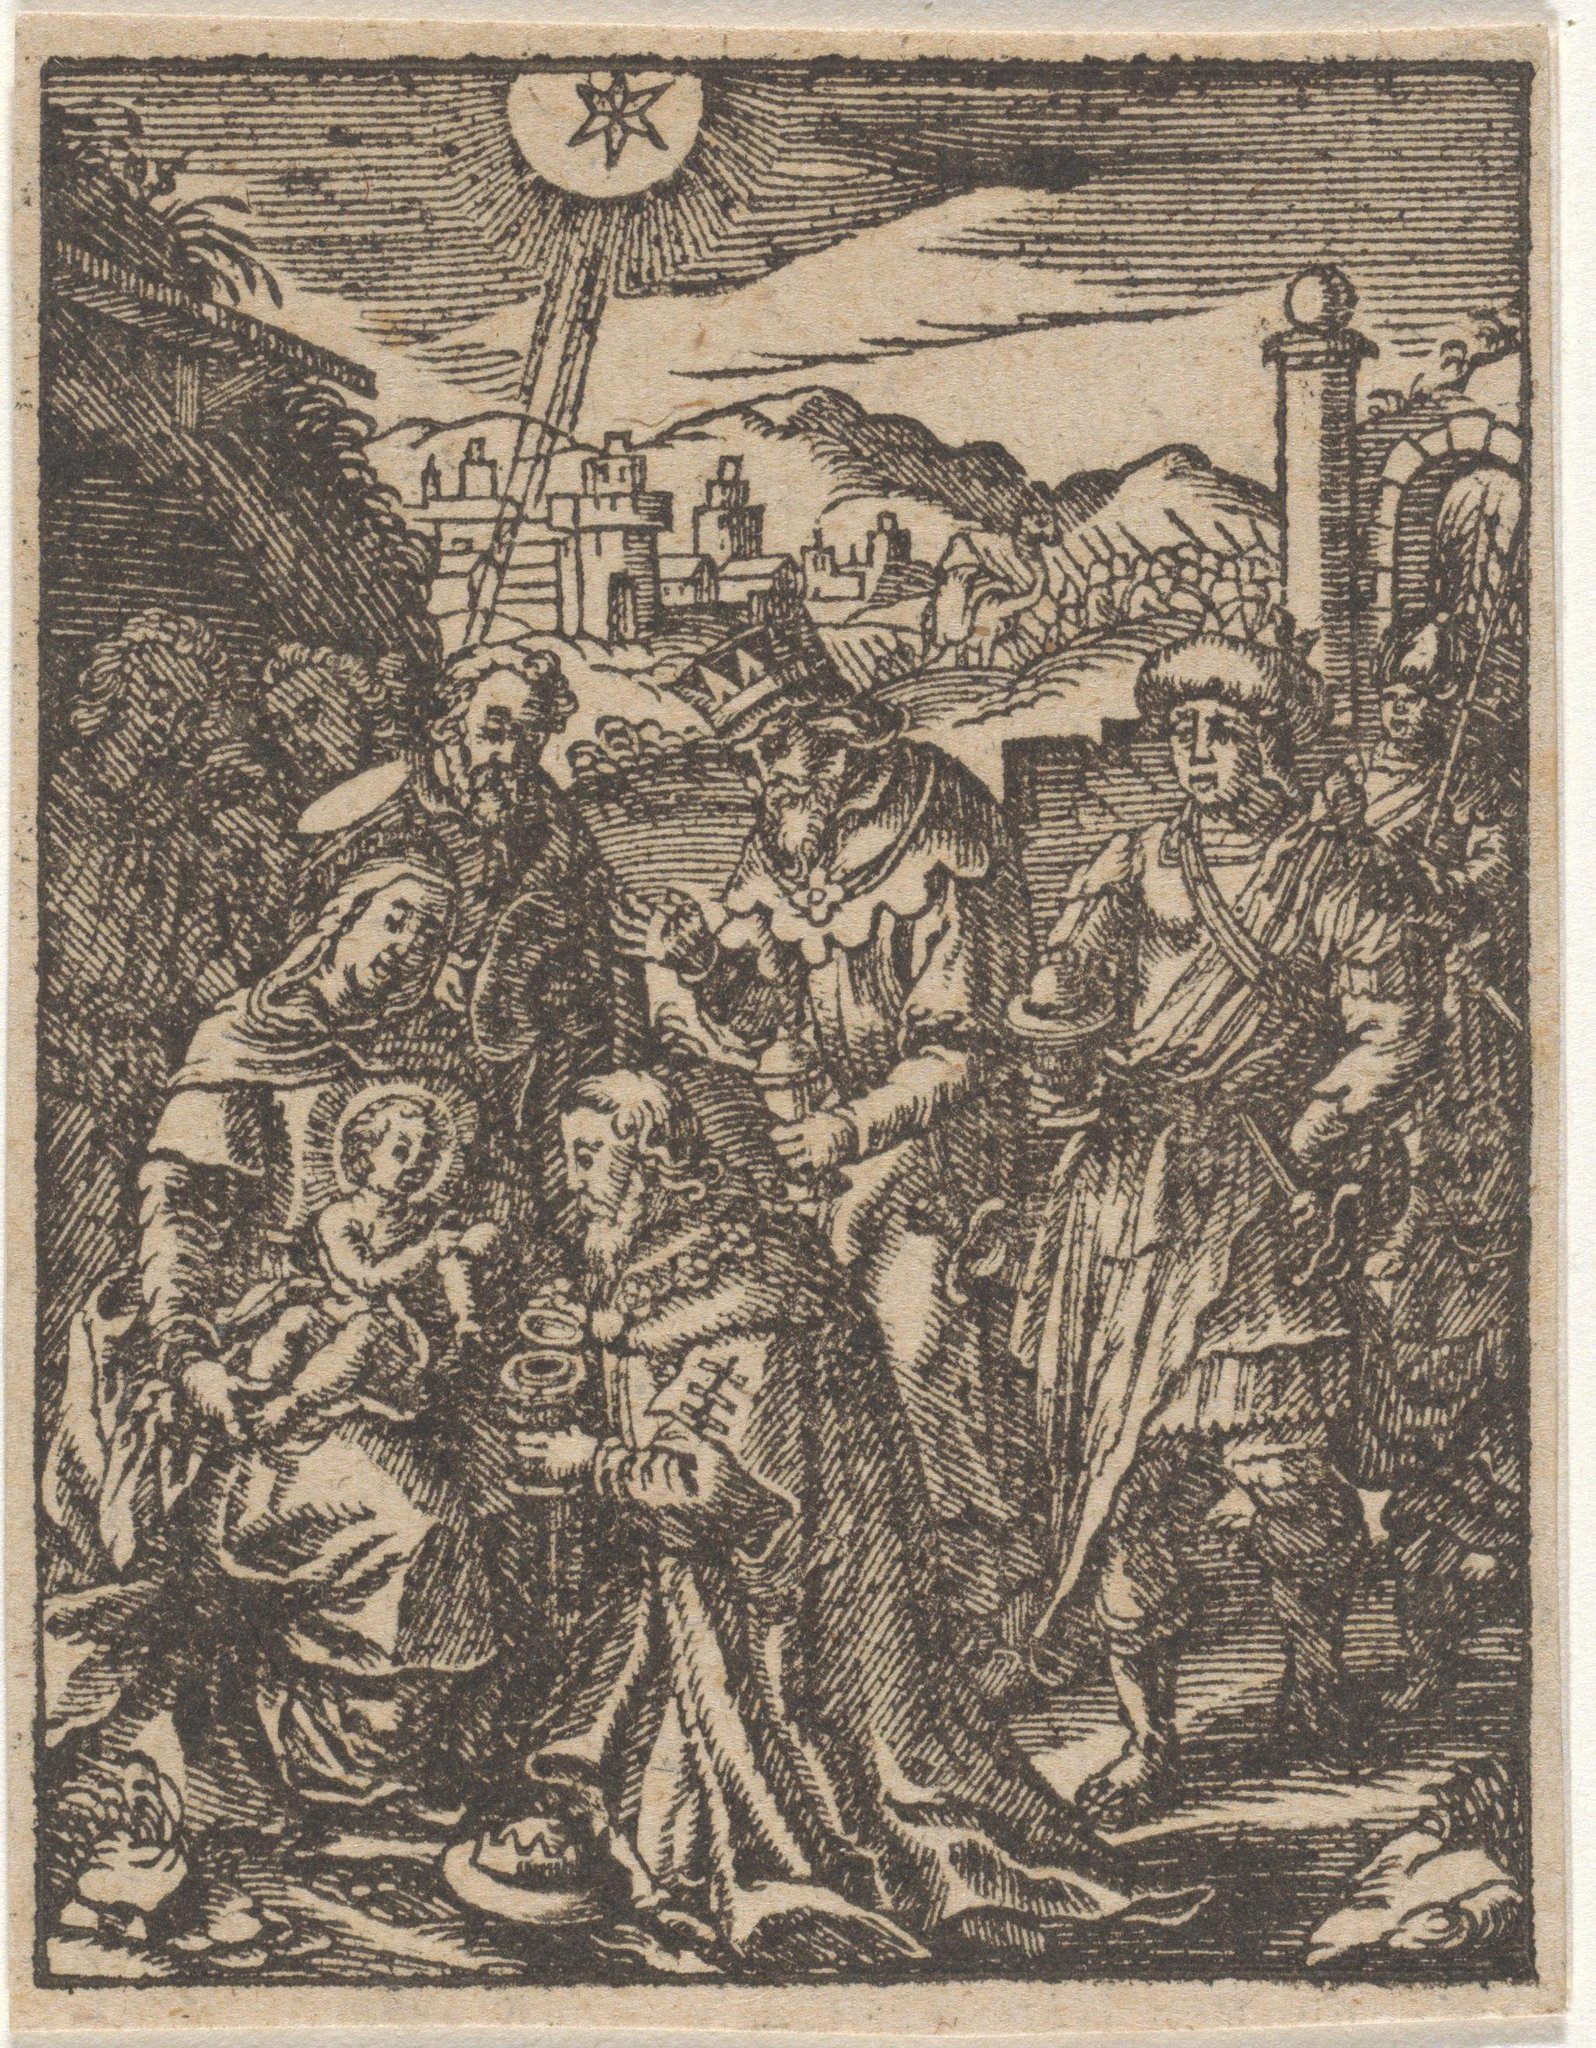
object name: print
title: Jeugd van Christus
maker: christoffel van sichem (ii)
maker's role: print maker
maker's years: 1581-1658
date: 1617-1658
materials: paper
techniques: woodcut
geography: amsterdam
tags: adoration of the kings: the wise men present their gifts to the christ-child (gold, frankincense and myrrh)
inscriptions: collector's mark: Lugt 240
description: De drie koningen brengen hun geschenken en aanbidden het Christuskind, dat op schoot zit bij Maria. Achter hen staan mannen uit hun gevolg. Een koning knielt voor het Kind.